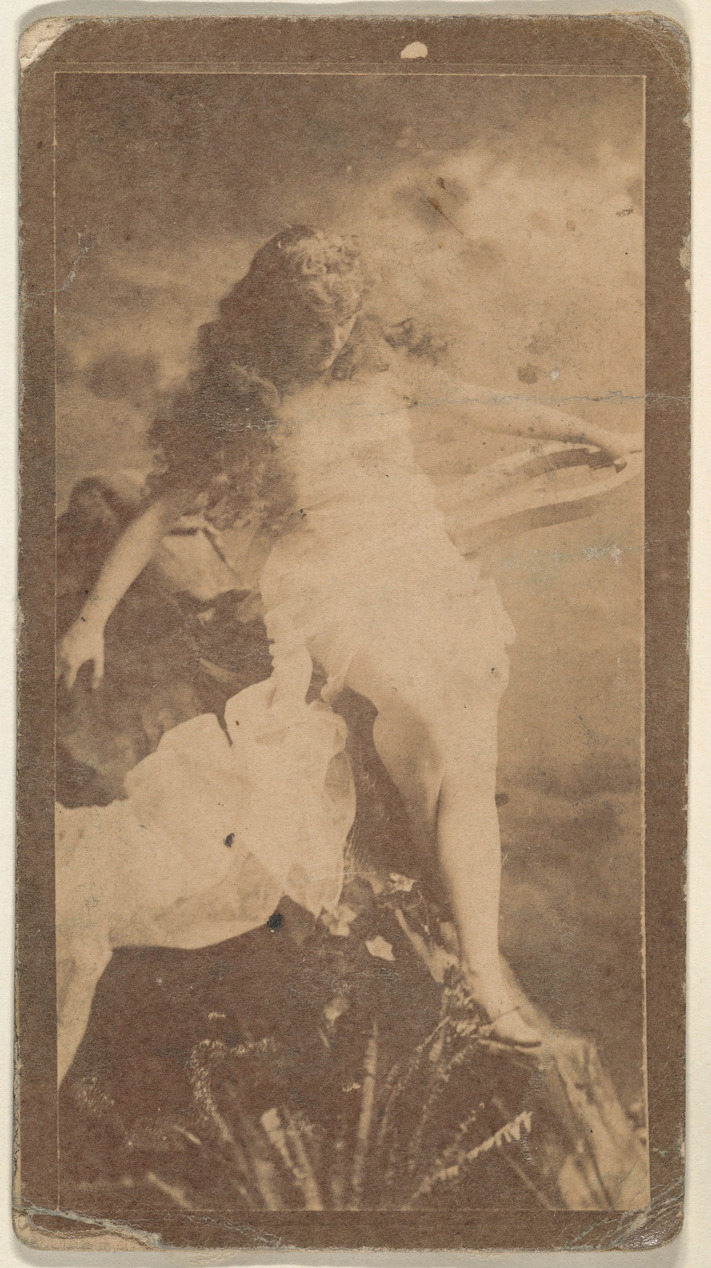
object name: photograph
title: Actress posing on prop boulders, from the Actresses series (N668)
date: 1888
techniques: albumen silver print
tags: portraits,women,actresses